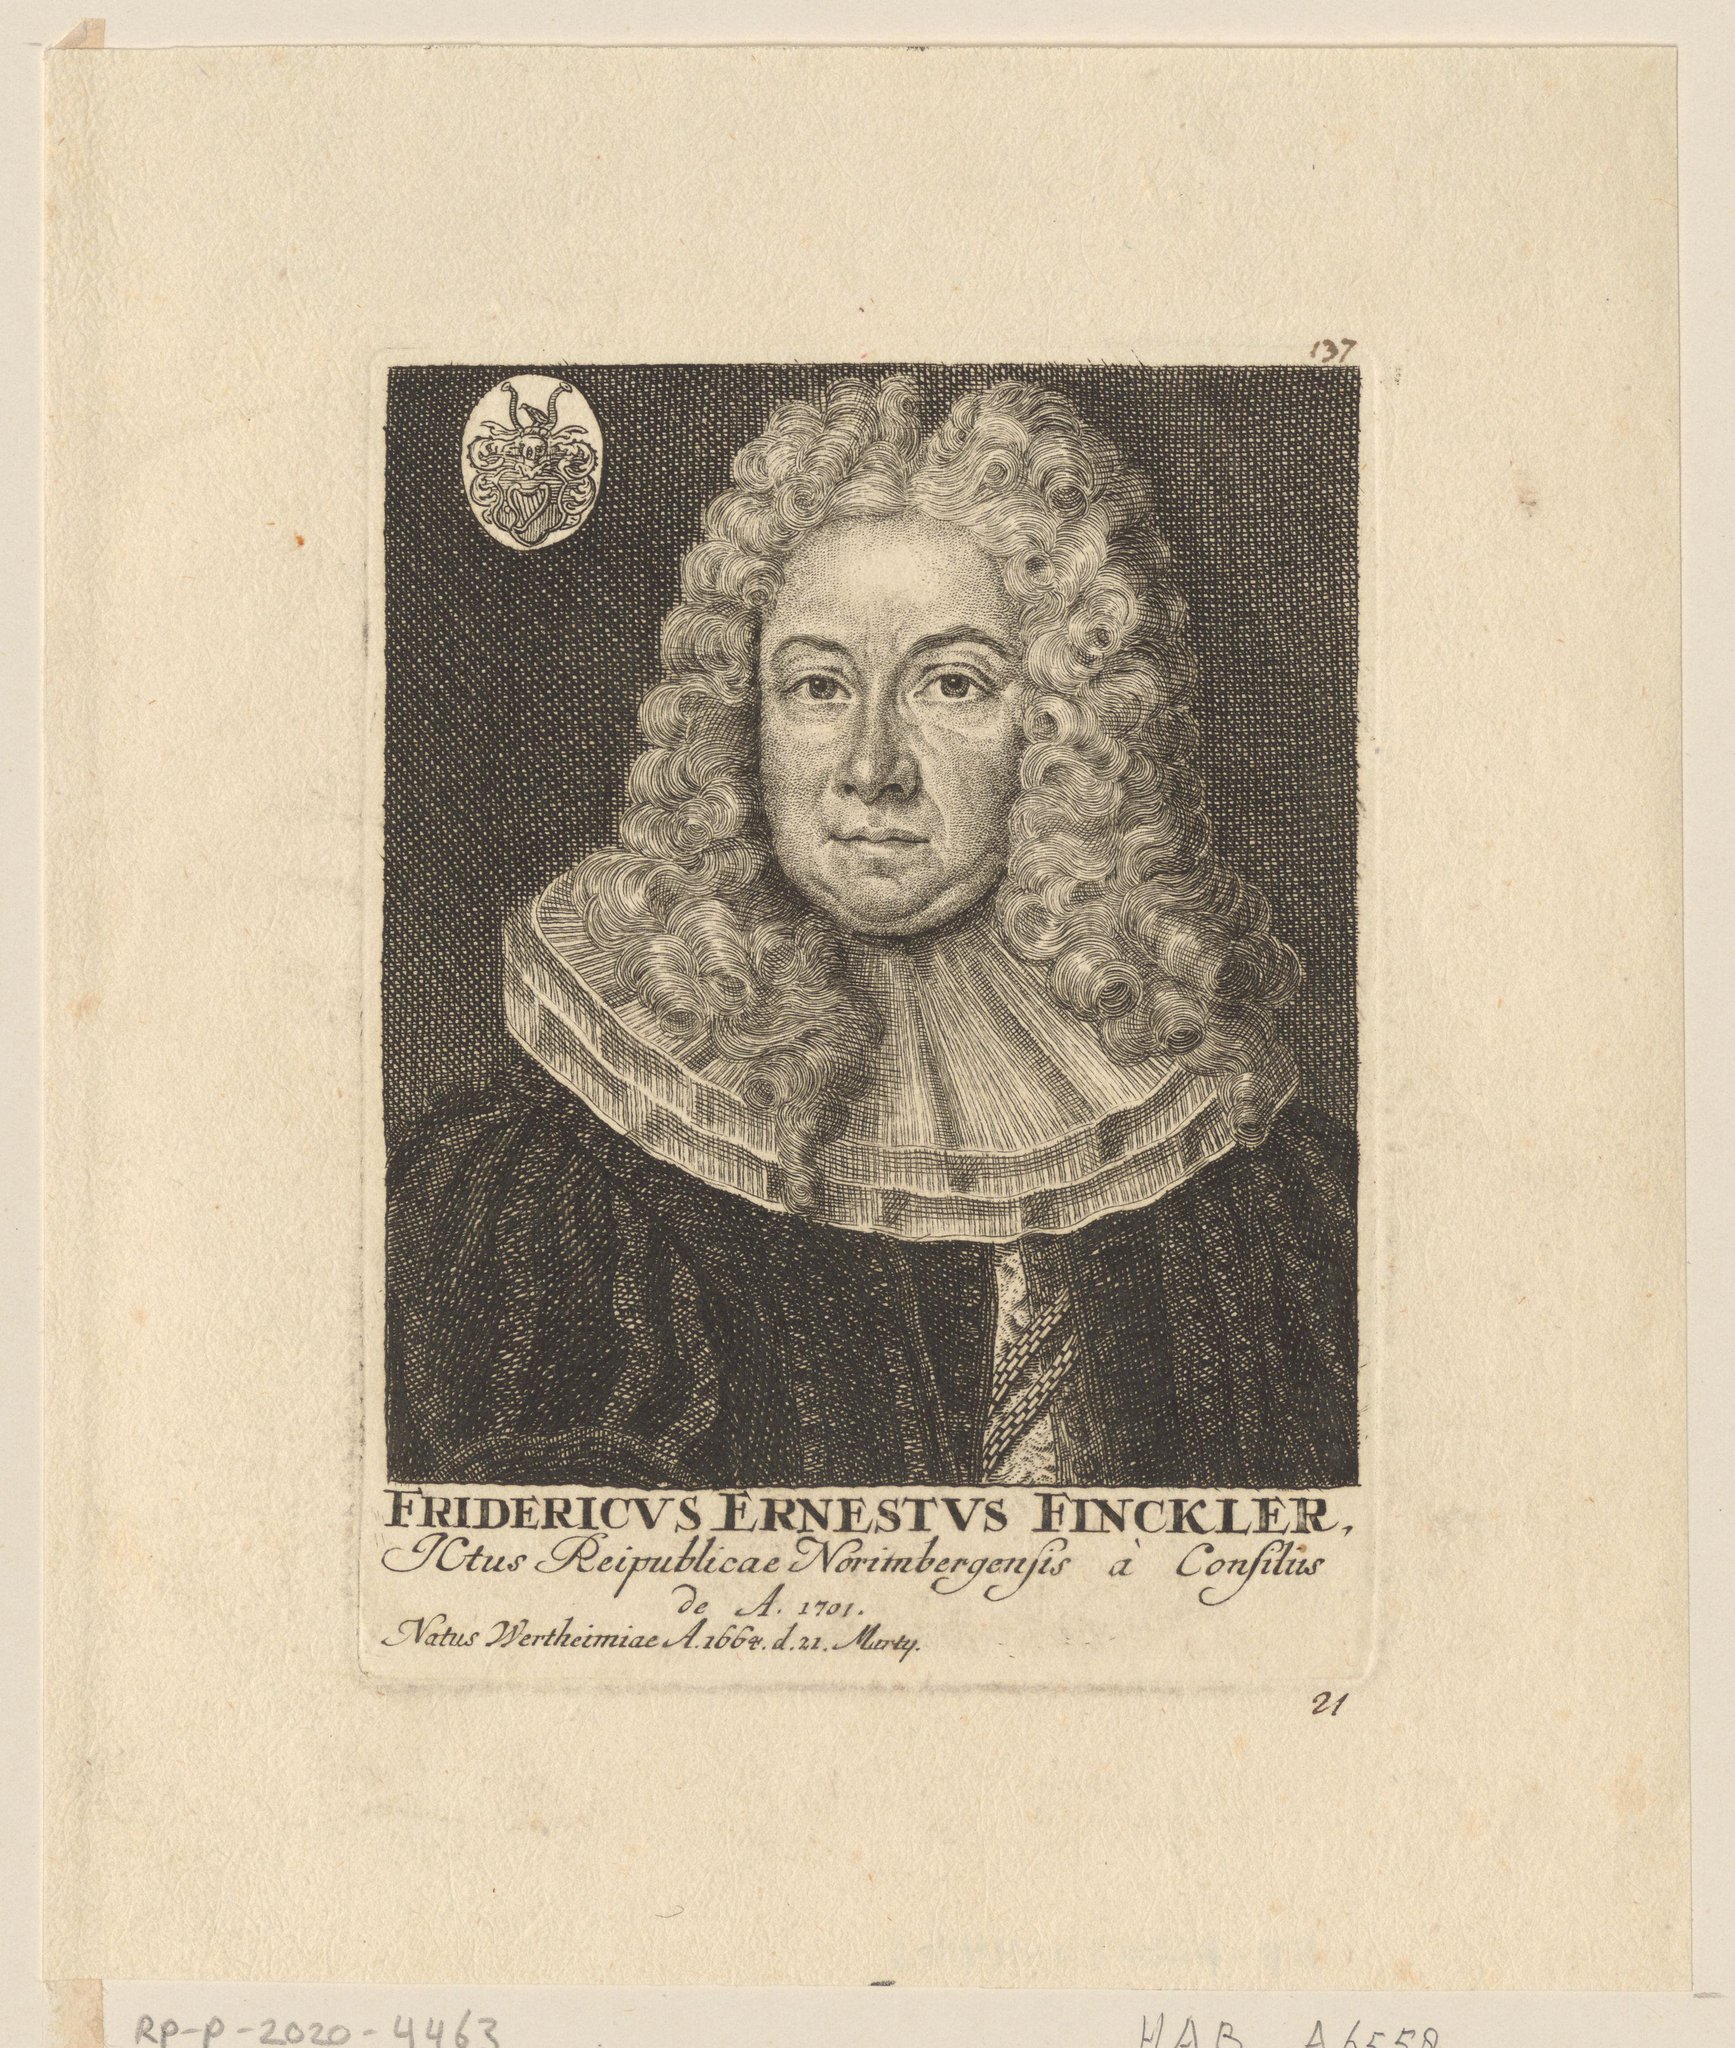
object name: book illustration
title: Portret van Friedrich Ernst Finckler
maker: Anonymous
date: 1725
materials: paper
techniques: engraving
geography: germany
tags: historical persons, armorial bearing, heraldry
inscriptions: number: ‘137’, number: ‘21’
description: Prent waarschijnlijk uit: Roth-Scholtz, Friedrich. Icones virorum omnium ordinum eruditione omnique item genere (...). Neurenberg: erven Johann Daniel Tauber, 1725.